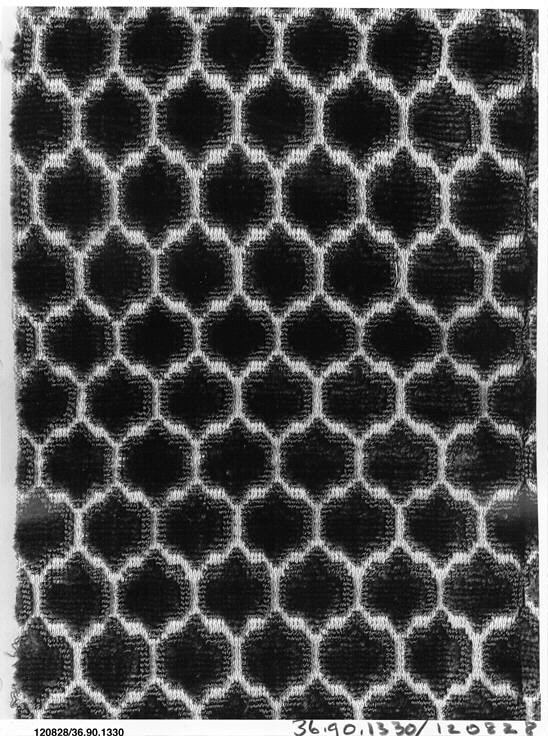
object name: piece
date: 1501-1700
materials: silk